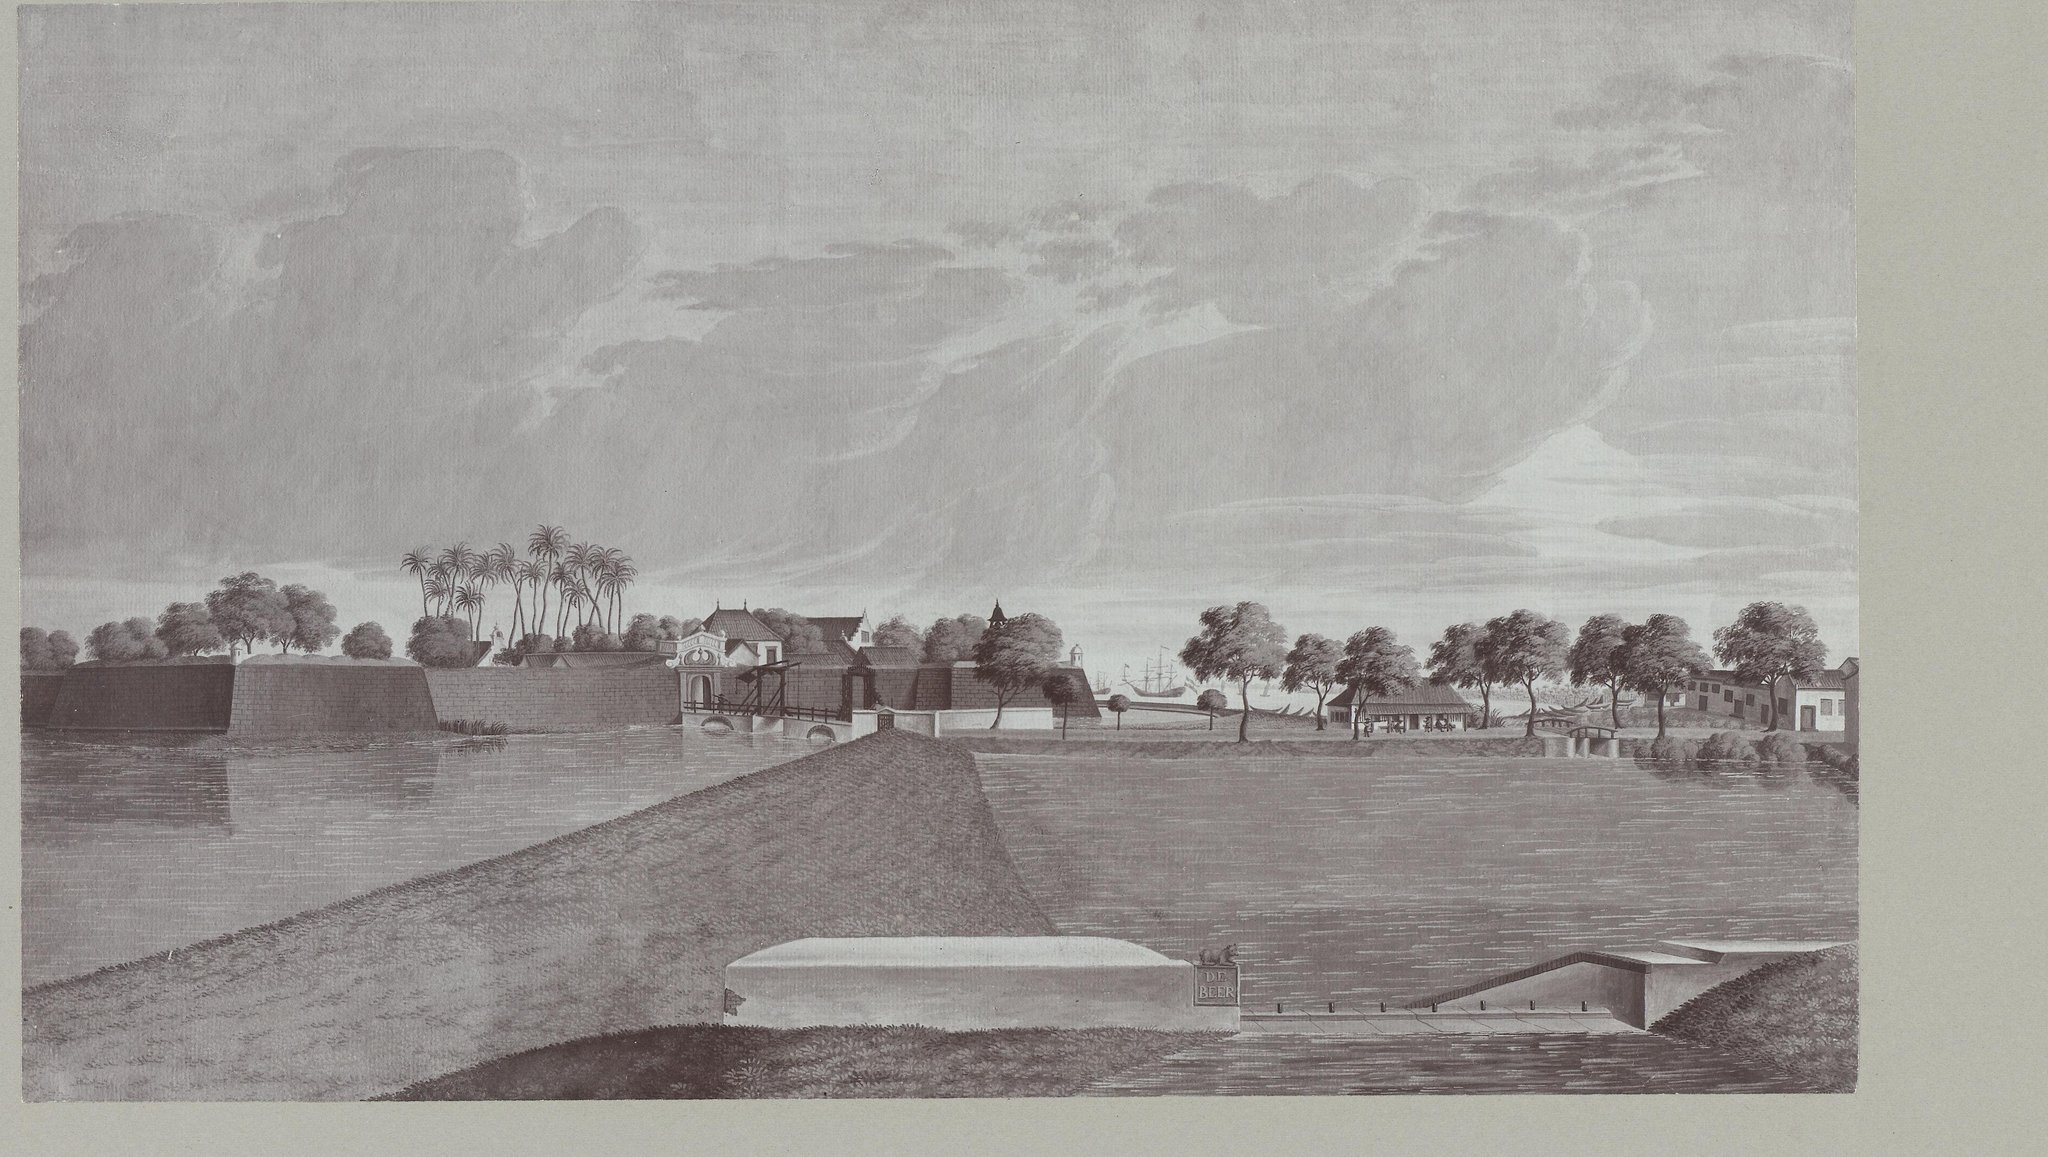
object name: photograph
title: Het kasteel Colombo van de beer gezien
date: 1890-1910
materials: cardboard, paper, photographic support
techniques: collodion silver print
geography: amsterdam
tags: drawing, sketch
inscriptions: check stamp: ‘Roeloffzen, Hübner & Van Santen’, title: ‘Het kasteel Colombo van de beer gezien’